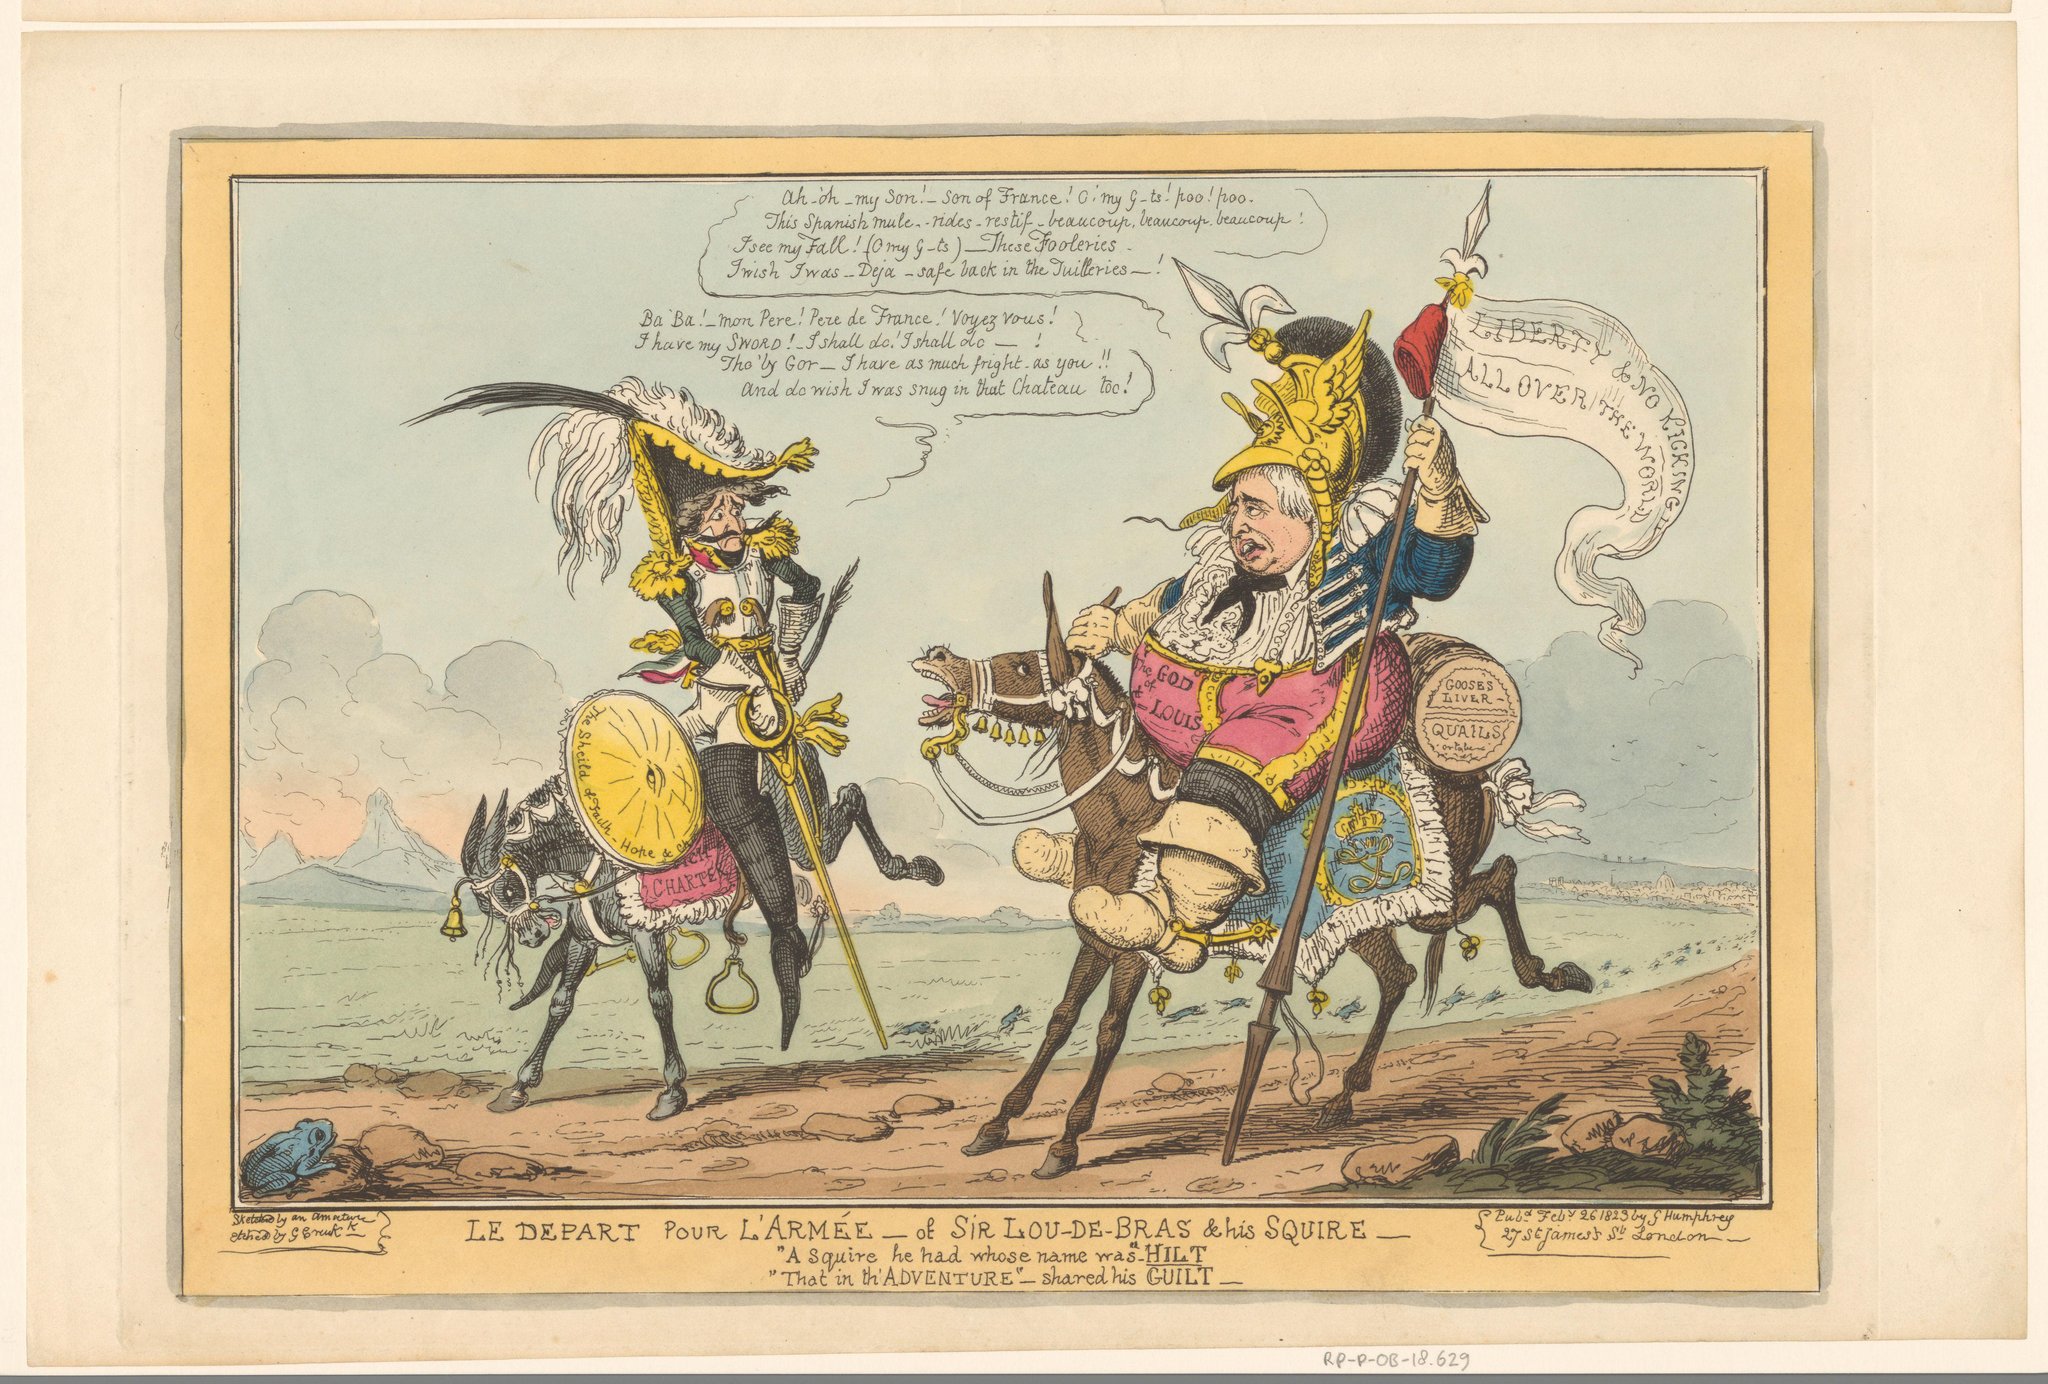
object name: print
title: Le Depart pour l'Armée - of Sir Lou-de-Bras & his Squire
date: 1802-1823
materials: paper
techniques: etching, hand coloring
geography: london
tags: paris, lodewijk xviii (koning van frankrijk), mule, political caricatures and satires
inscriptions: collector's mark: Lugt 2228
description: Spotprent op de Franse invasie in Spanje, 1823.